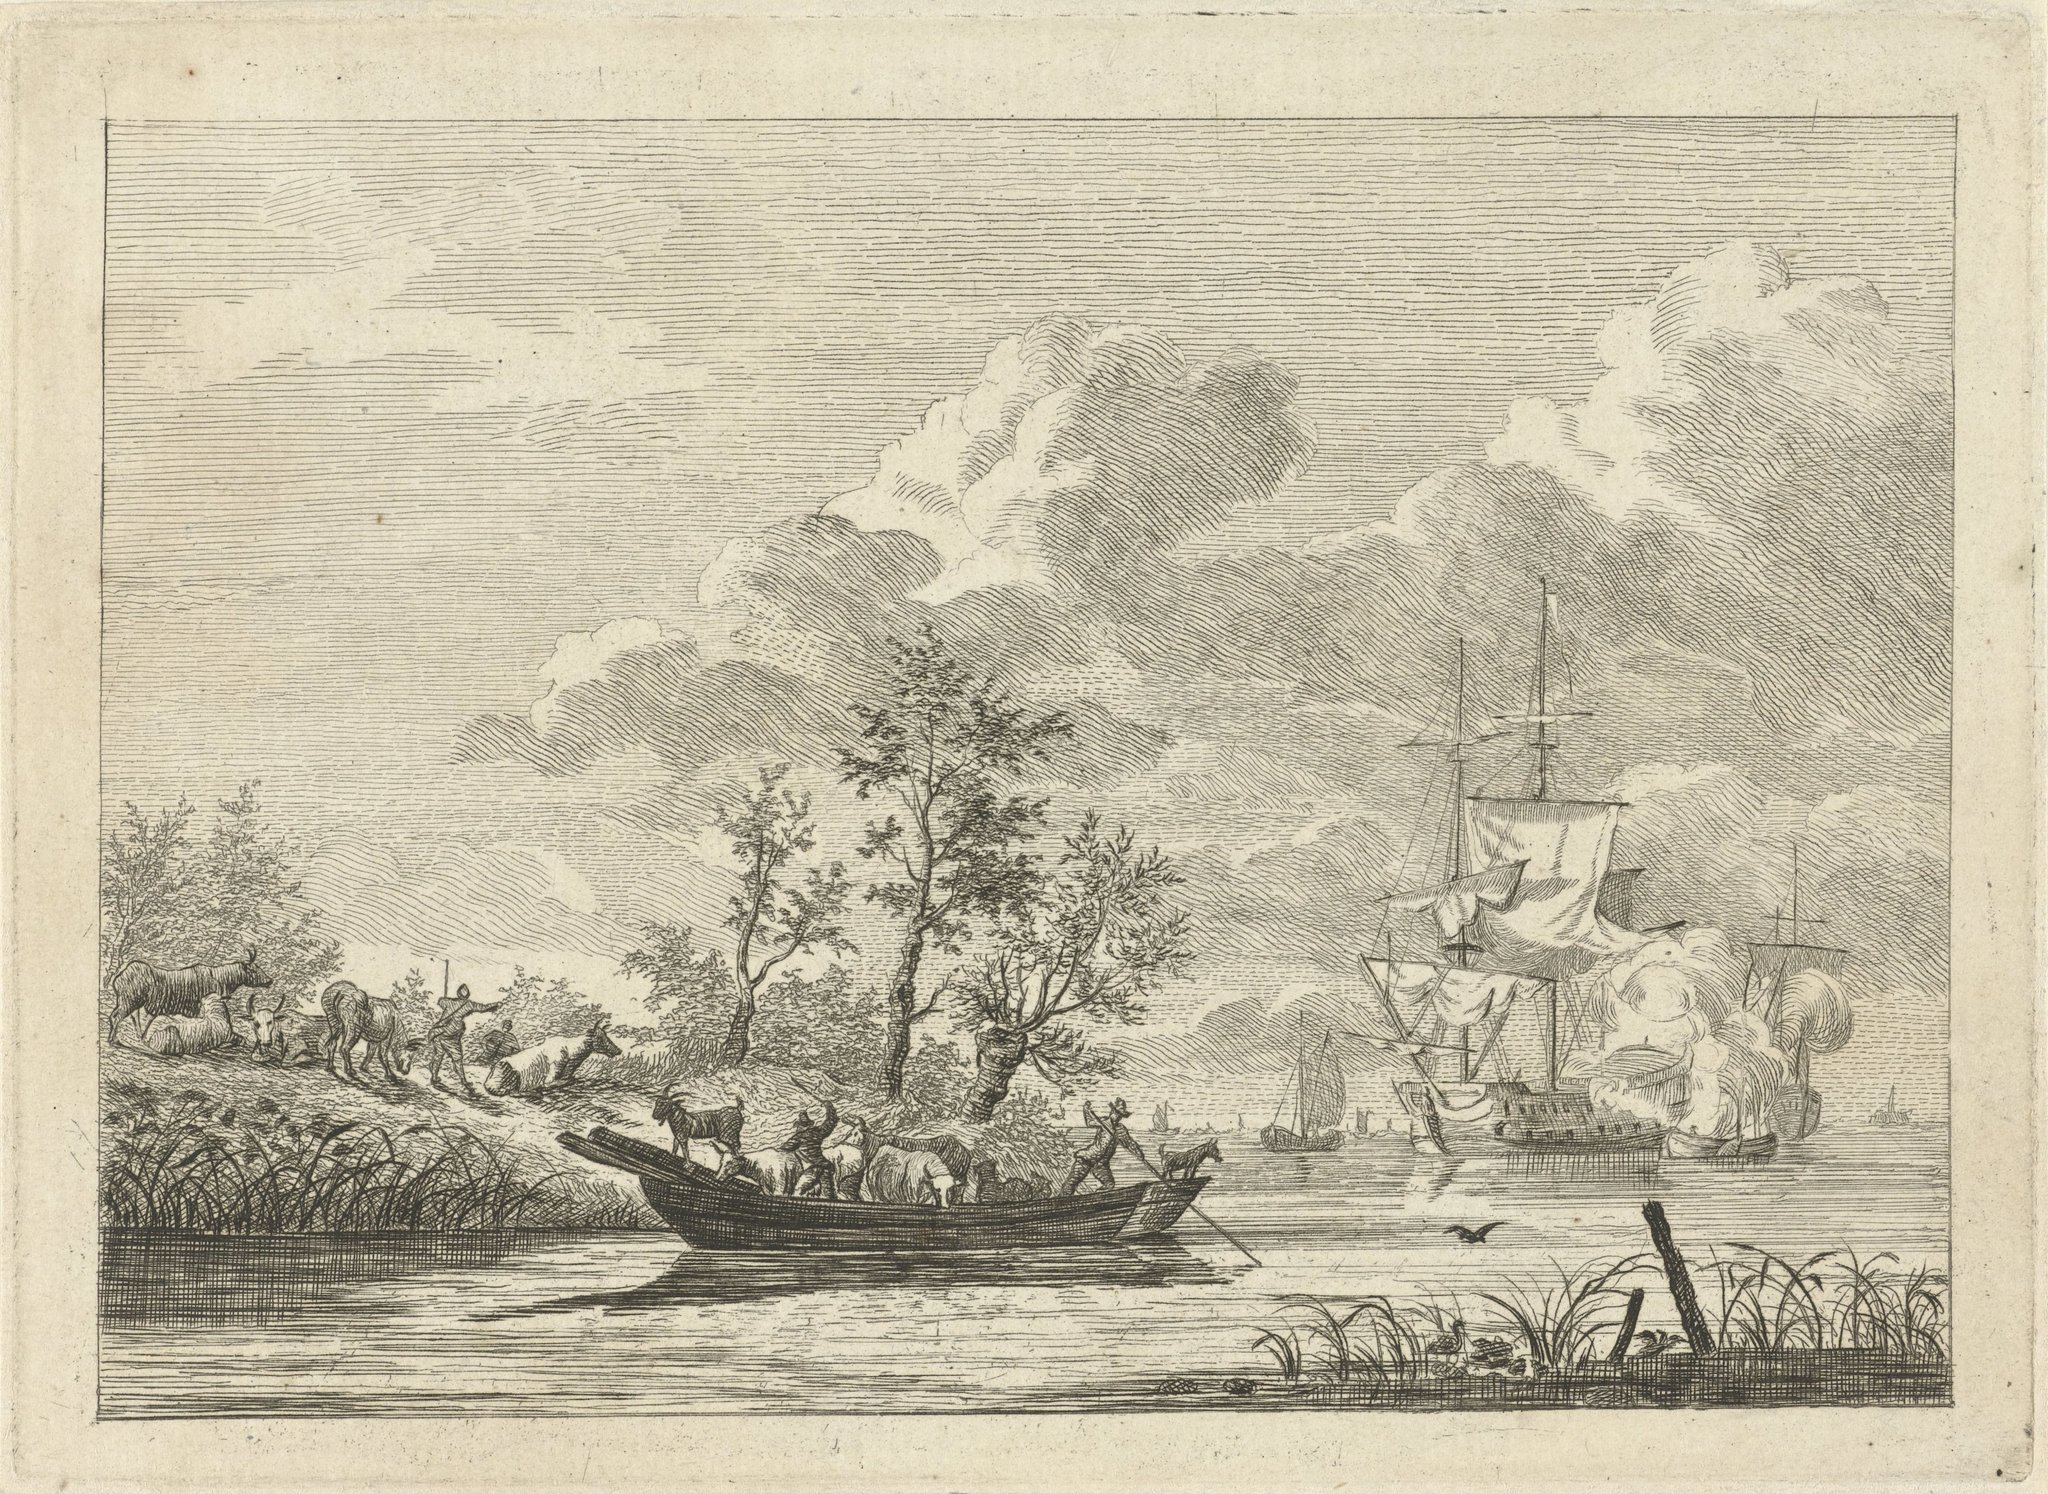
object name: print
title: Riviergezicht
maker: gerrit groenewegen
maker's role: draughtsman, print maker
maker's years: 1754-1826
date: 1764-1826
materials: paper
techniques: engraving, etching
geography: rotterdam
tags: ships (in general) - cc - more than one ship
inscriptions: collector's mark: Lugt 2228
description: Op de voorgrond een schuit met vee en twee figuren. Links aan wal staan vijf koeien en twee mannen. Op de achtergrond is een aantal schepen te zien.